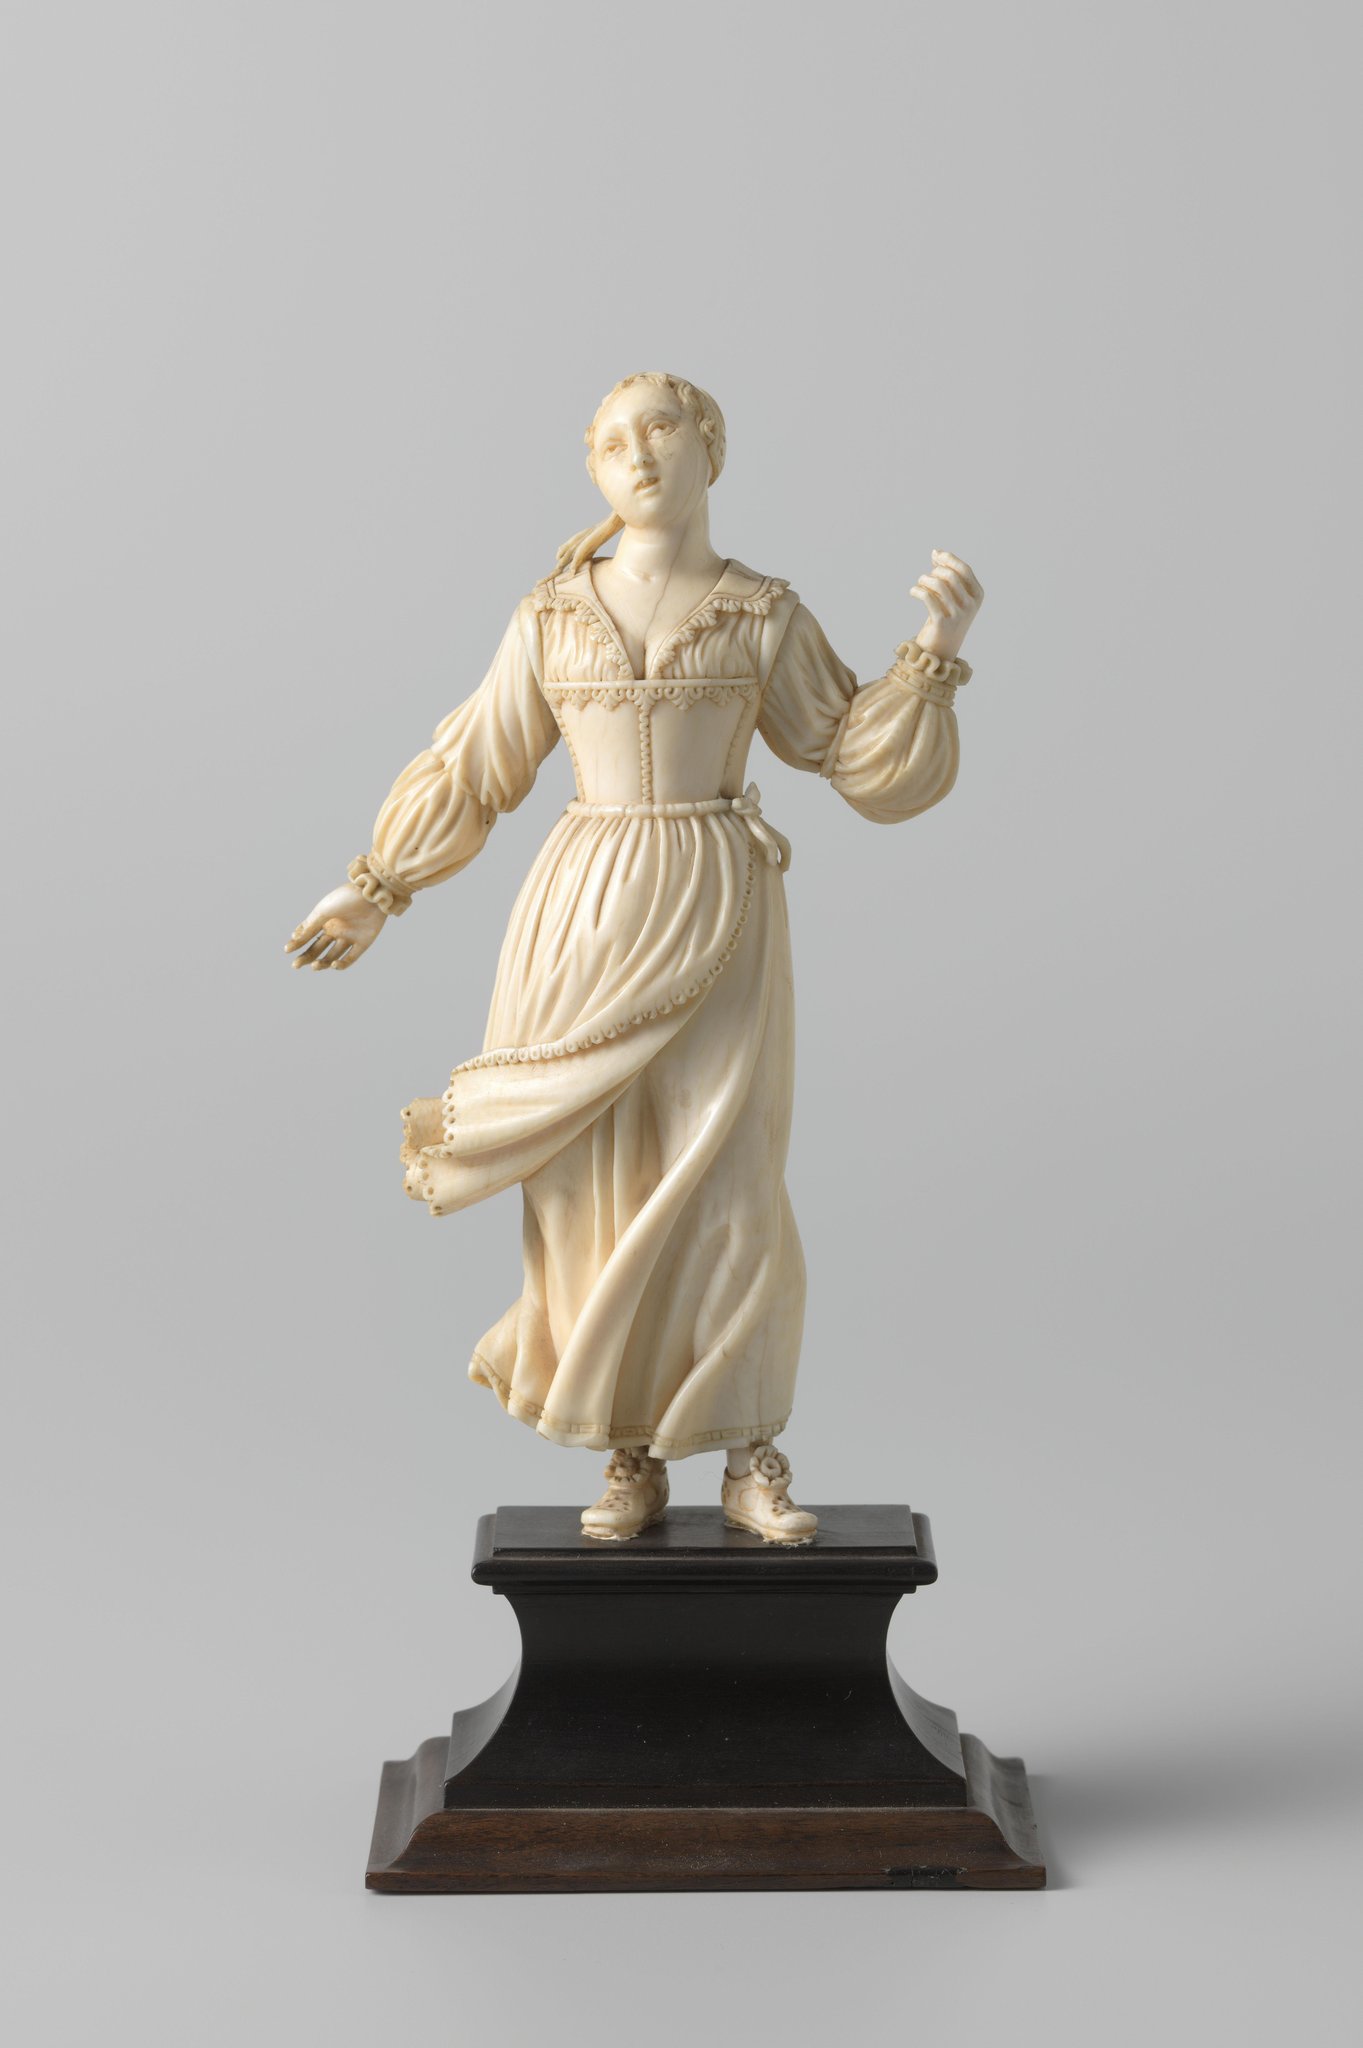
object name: sculpture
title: vrouw met spinrokken.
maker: Anonymous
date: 1700-1800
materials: ivory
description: Figuur van ivoor, in de vorm van een vrouwspersoon met spinrokken in de hand.